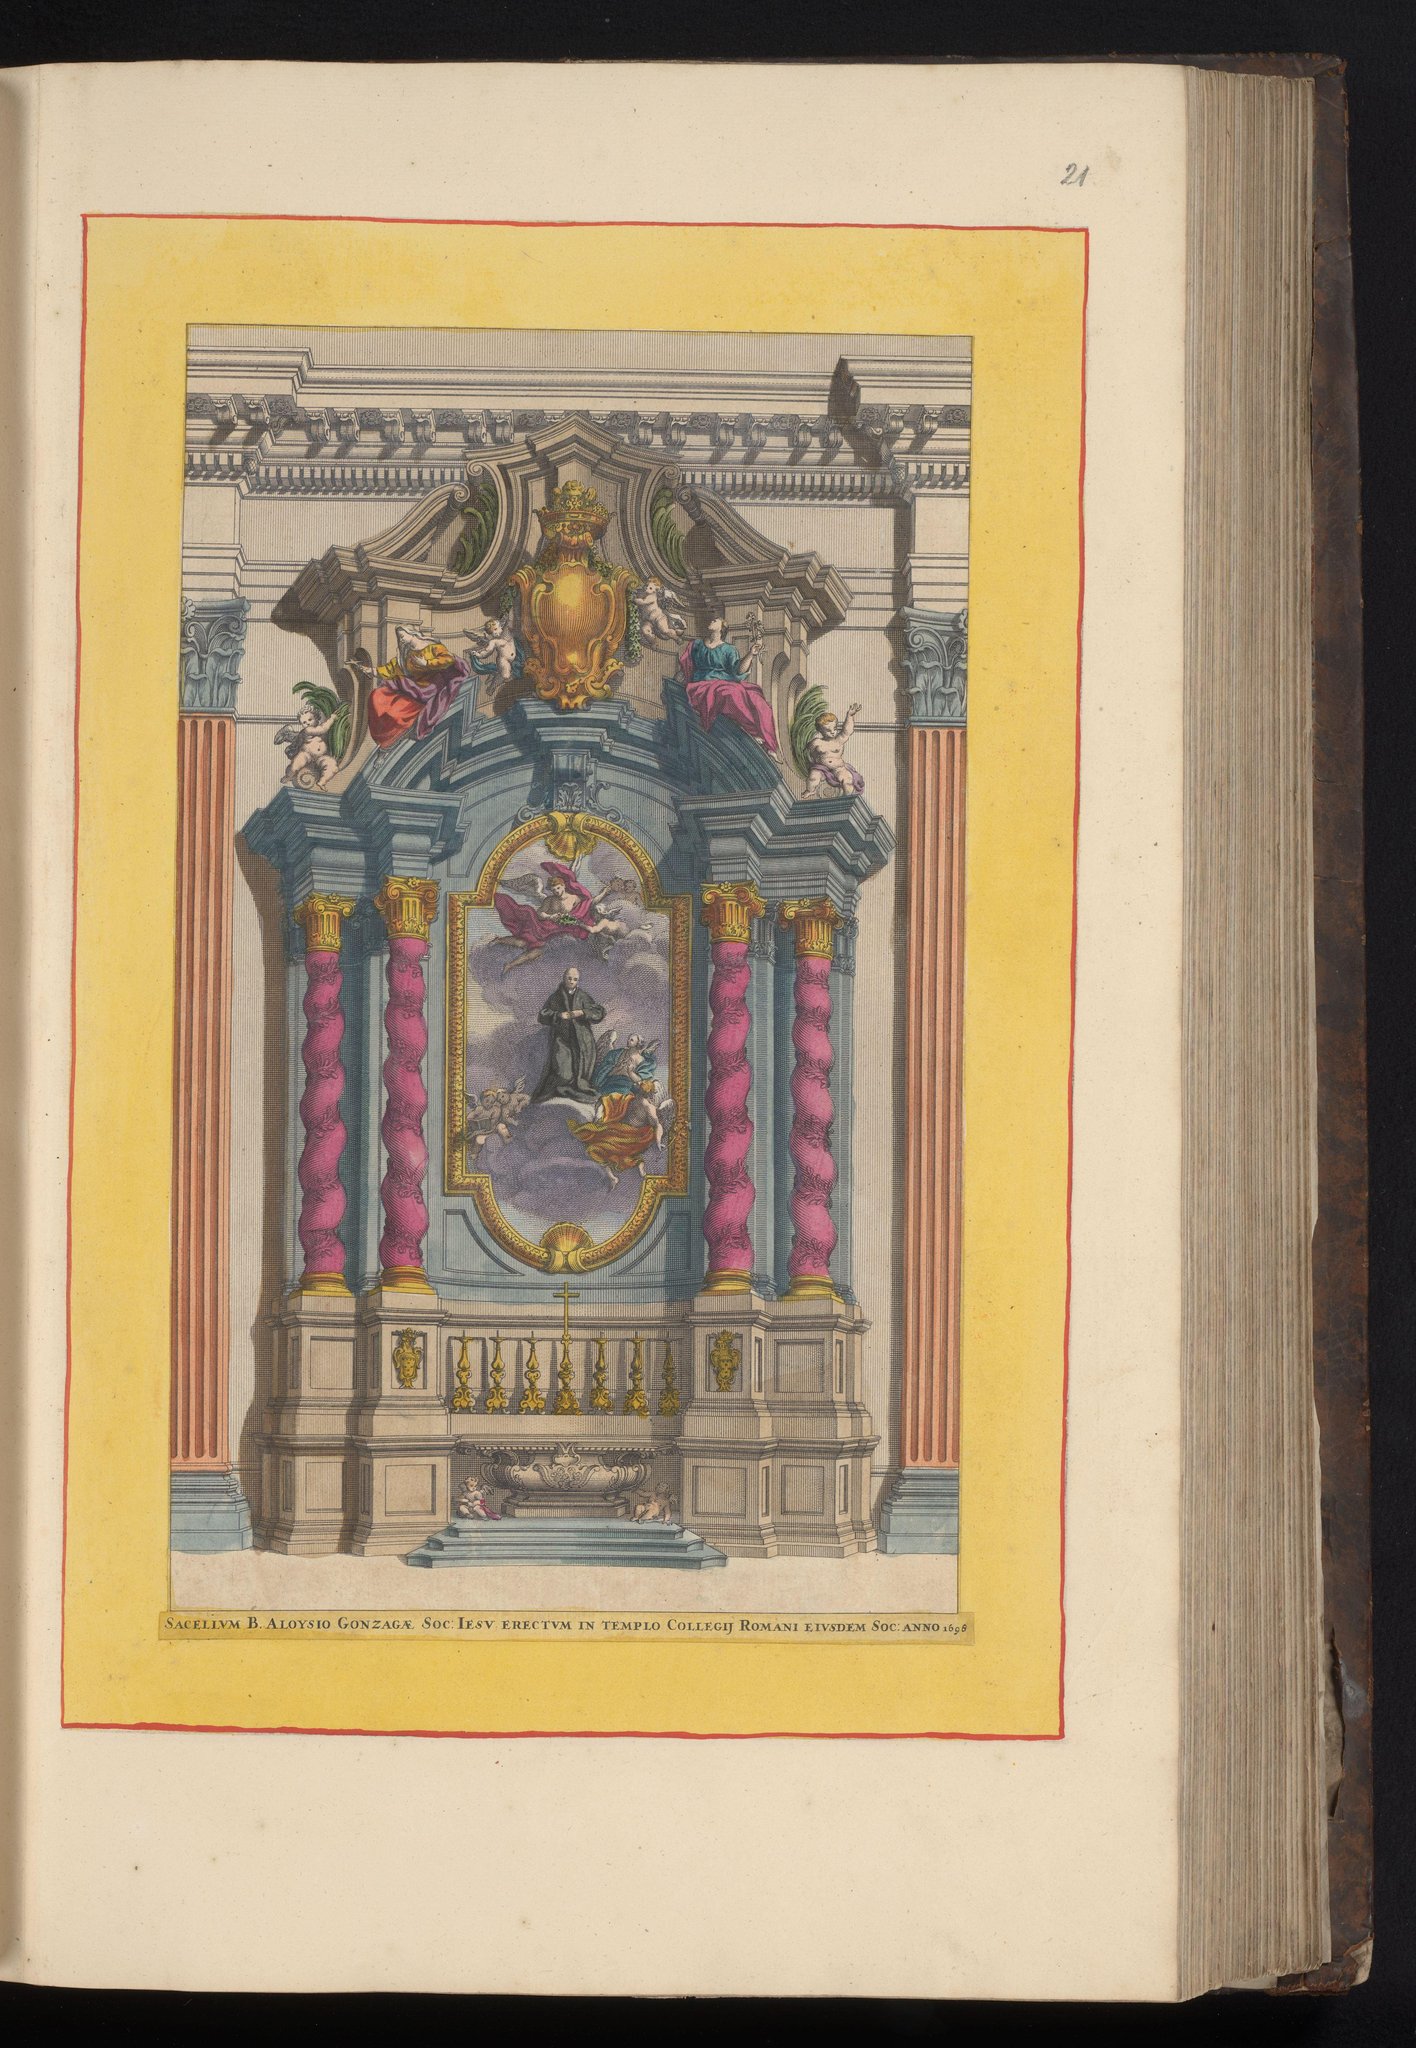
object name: print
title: Sacellum B. Aloysio Gonzagae Soc: Iesu erectum in templo collegij Romani eiusdem soc: anno 1698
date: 1693-1717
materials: paper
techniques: colour, etching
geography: italy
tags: the jesuit friar aloysius gonzaga; possible attributes: crucifix, discipline, lily, skull, triumphal arch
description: Altaar voor Aloysius Gonzaga in de Sant'Ignazio di Loyola te Rome, met een gebeeldhouwd reliëf met een voorstelling van Aloysius Gonzaga, getordeerde zuilen, sculpturen en een wapenschild. Prent maakt deel uit van een album.